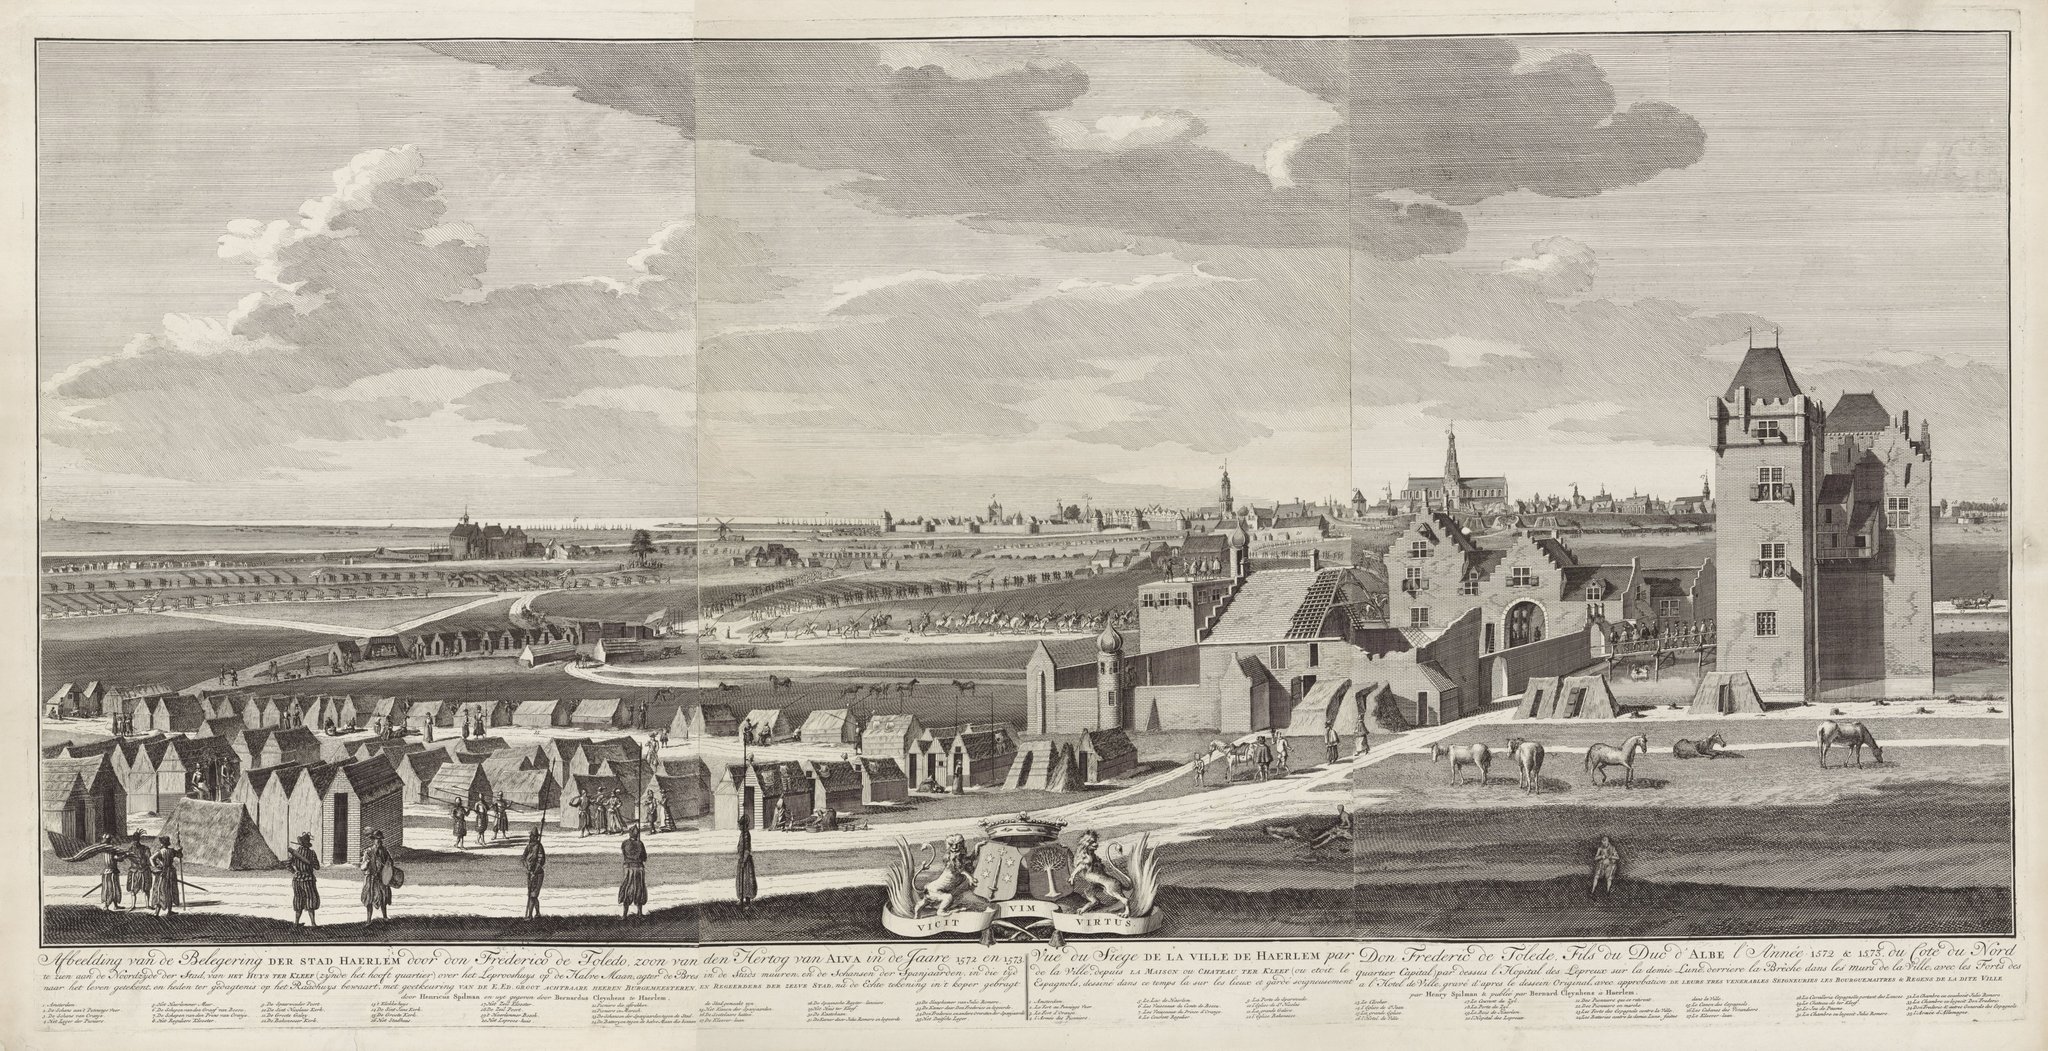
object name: print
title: Beleg van Haarlem, 1572-1573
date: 1742-1779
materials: paper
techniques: etching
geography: haarlem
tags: siege, position war, haarlem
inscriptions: collector's mark: Lugt 2228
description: Belegering van de stad Haarlem in de jaren 1572-1573 door de Spanjaarden onder Fadrique Alvarez de Toledo (Don Frederik), de zoon van de hertog van Alva. Grote voorstelling met een gezicht op de stad vanuit het noorden, in prent naar een eigentijdse tekening in drie bladen. Onder in het midden het wapen van Haarlem. Rechts het Huis ter Kleef, in de verte de Sint Bavo. Onder de voorstelling de titels en de legenda's 1-35 in het Nederlands en Frans.